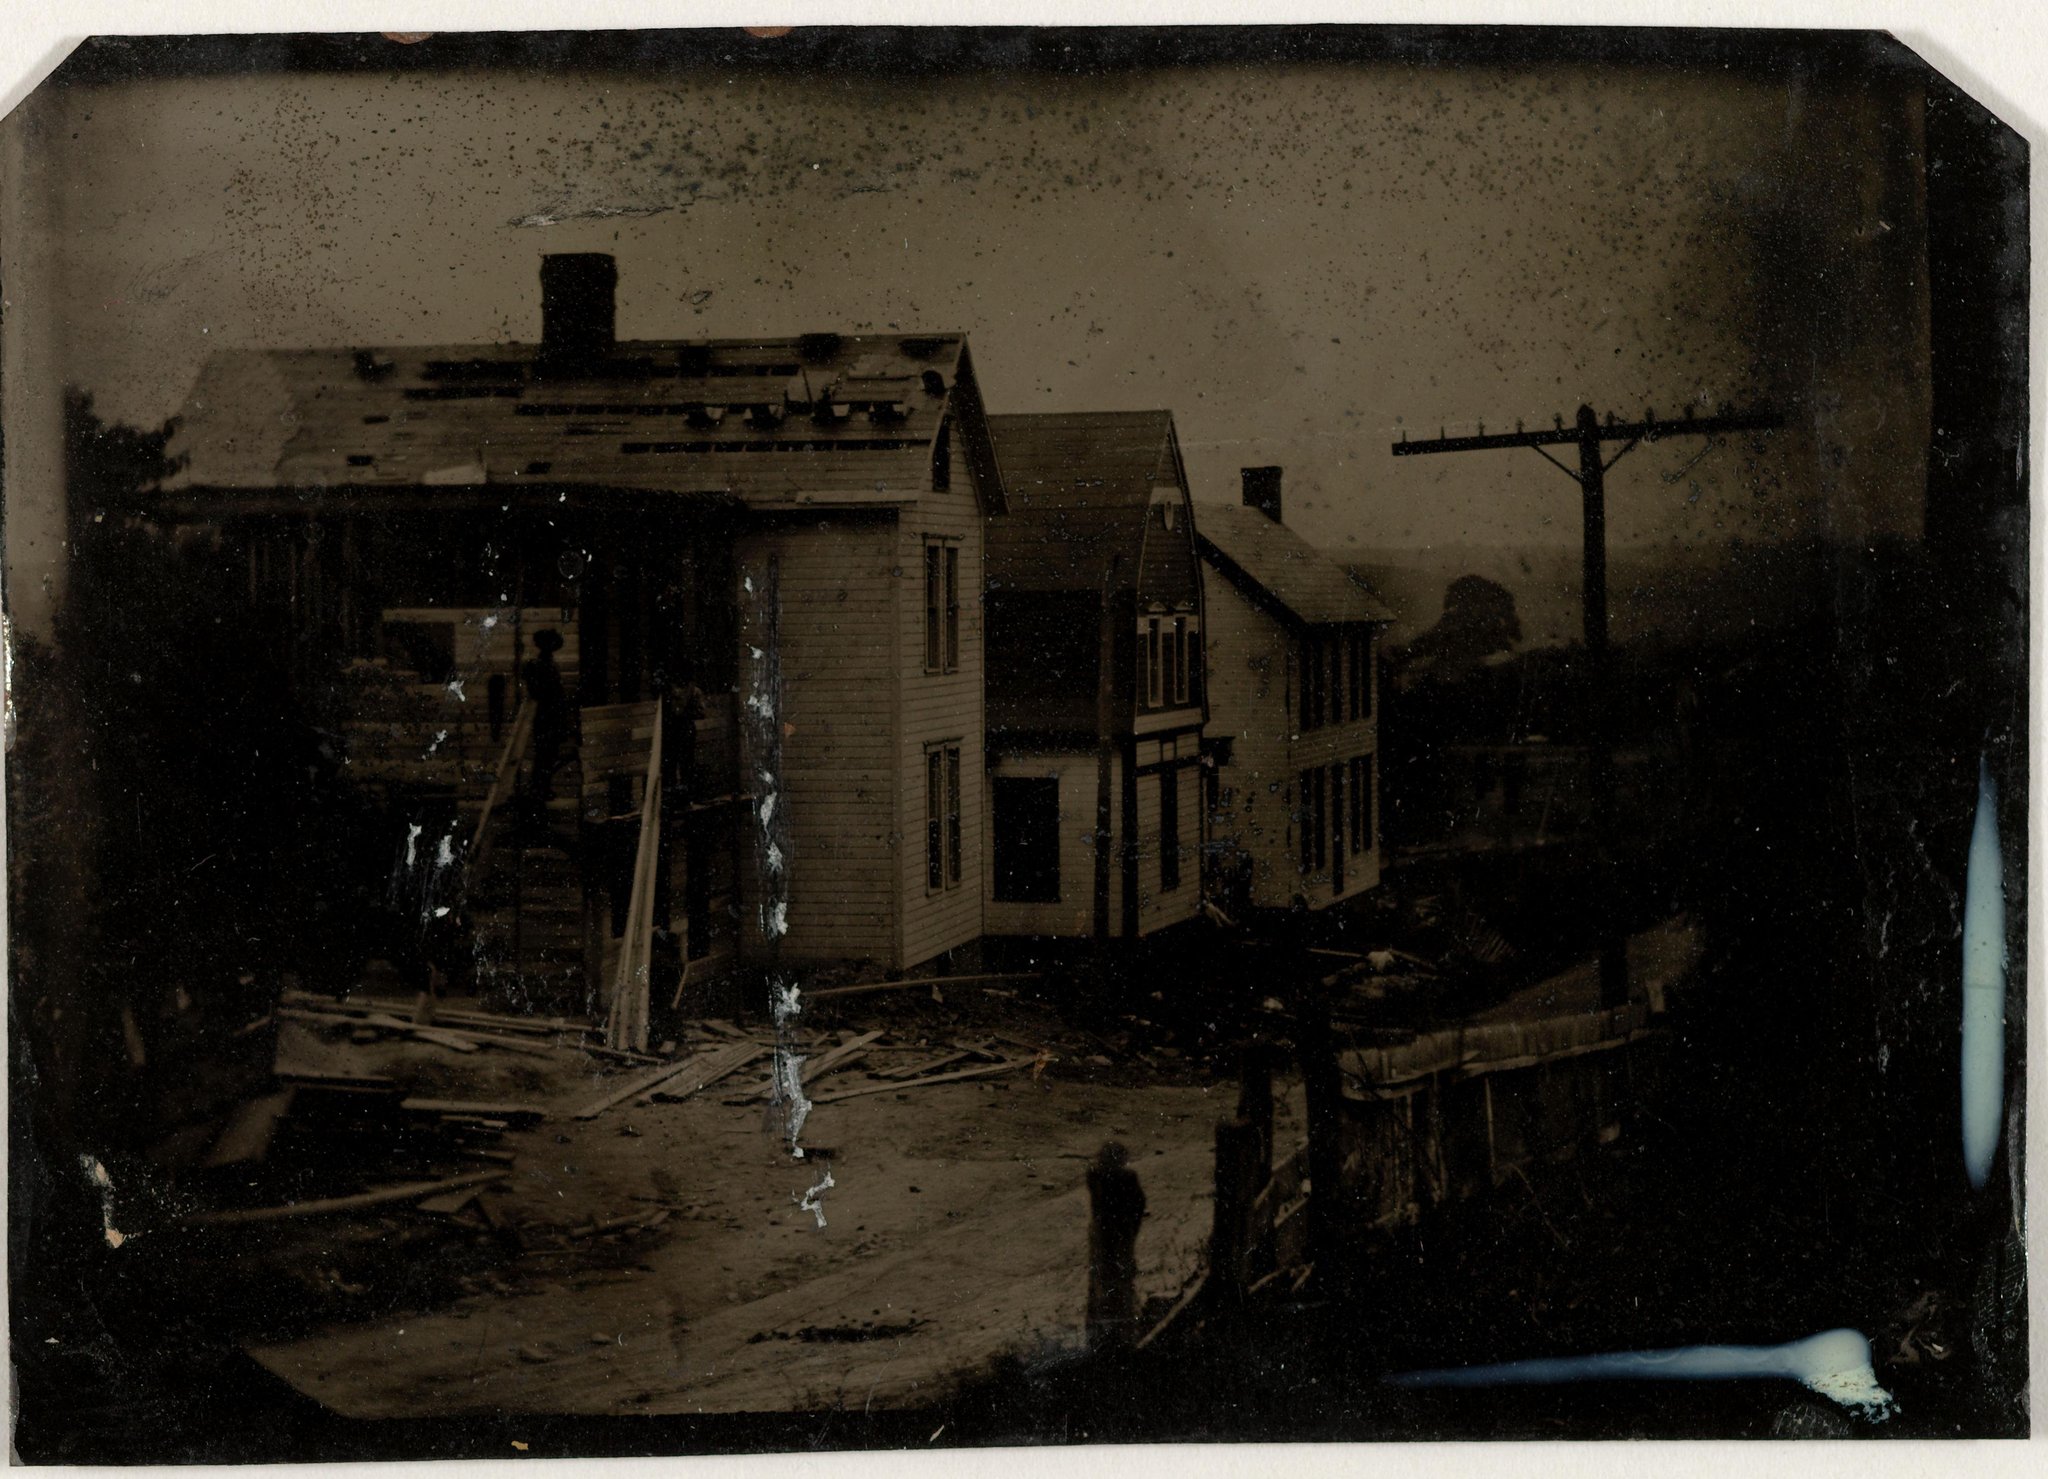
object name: photograph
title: Bouw van een huis in Masontown, Verenigde Staten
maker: Anonymous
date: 1879-1890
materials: metal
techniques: ferrotyping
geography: united states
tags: urban housing, united states of america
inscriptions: inscription: ‘The erection of a / house in Masontown’